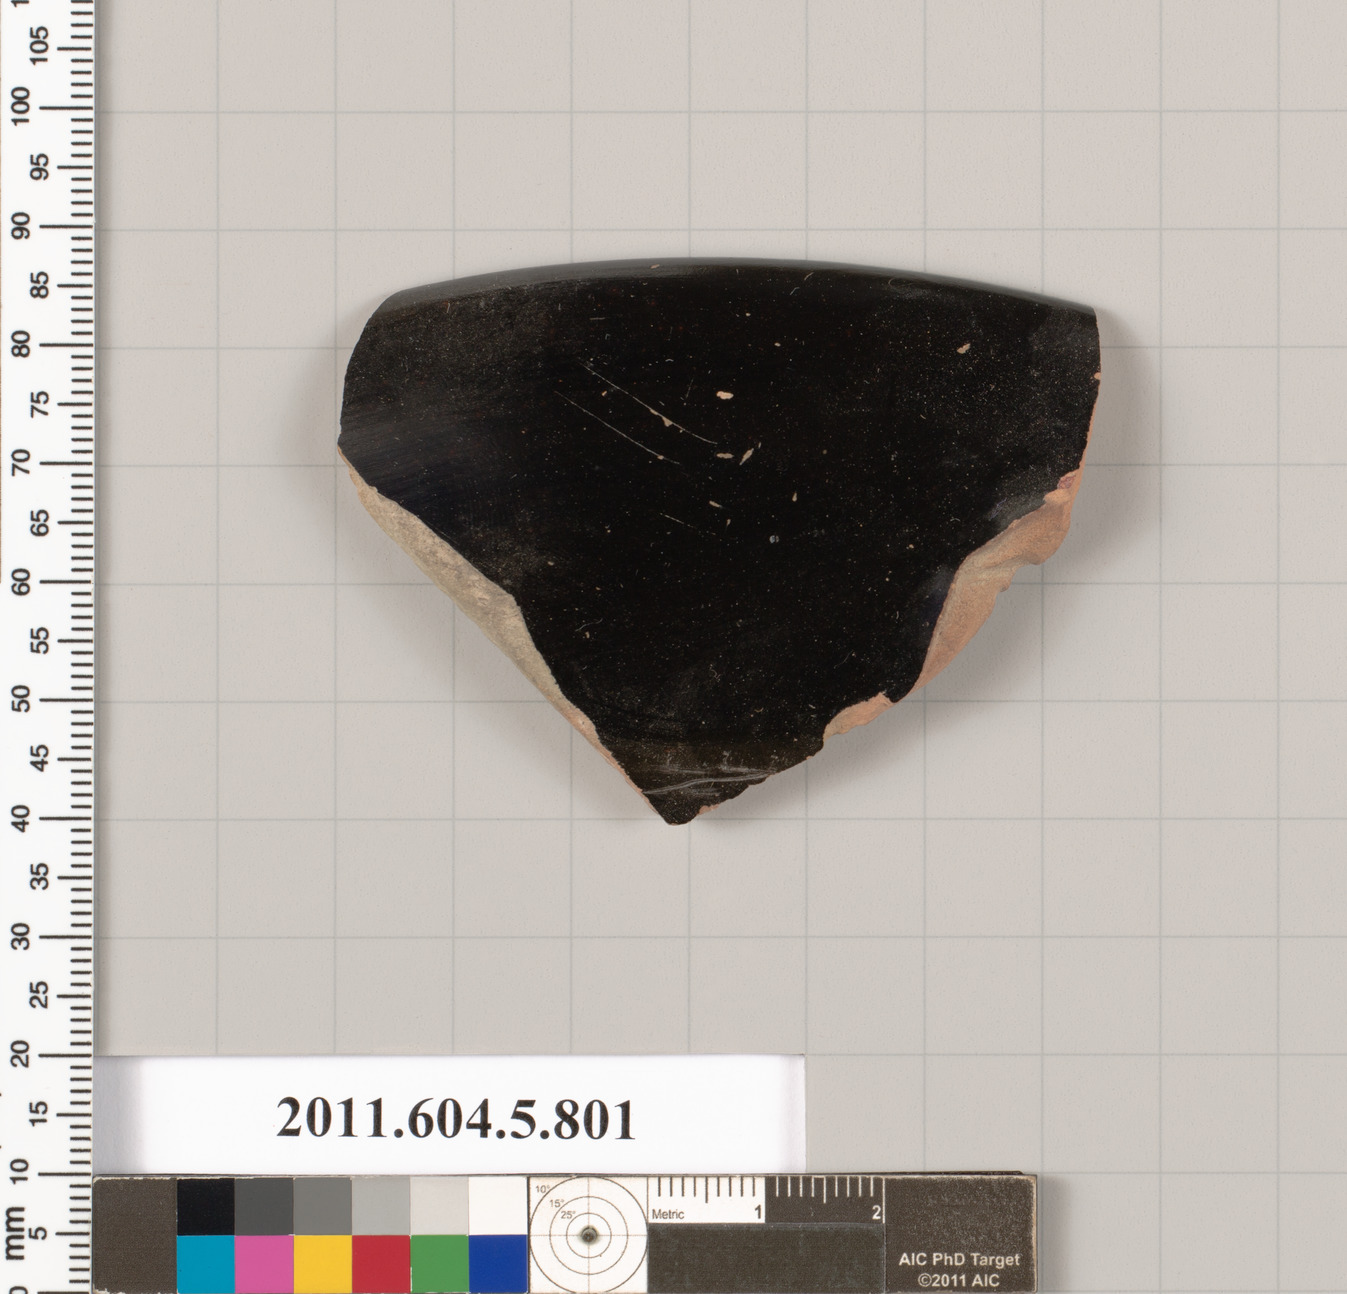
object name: kylix fragment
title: Terracotta rim fragment of a kylix (drinking cup)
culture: greek, attic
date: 600-401 BCE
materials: terracotta